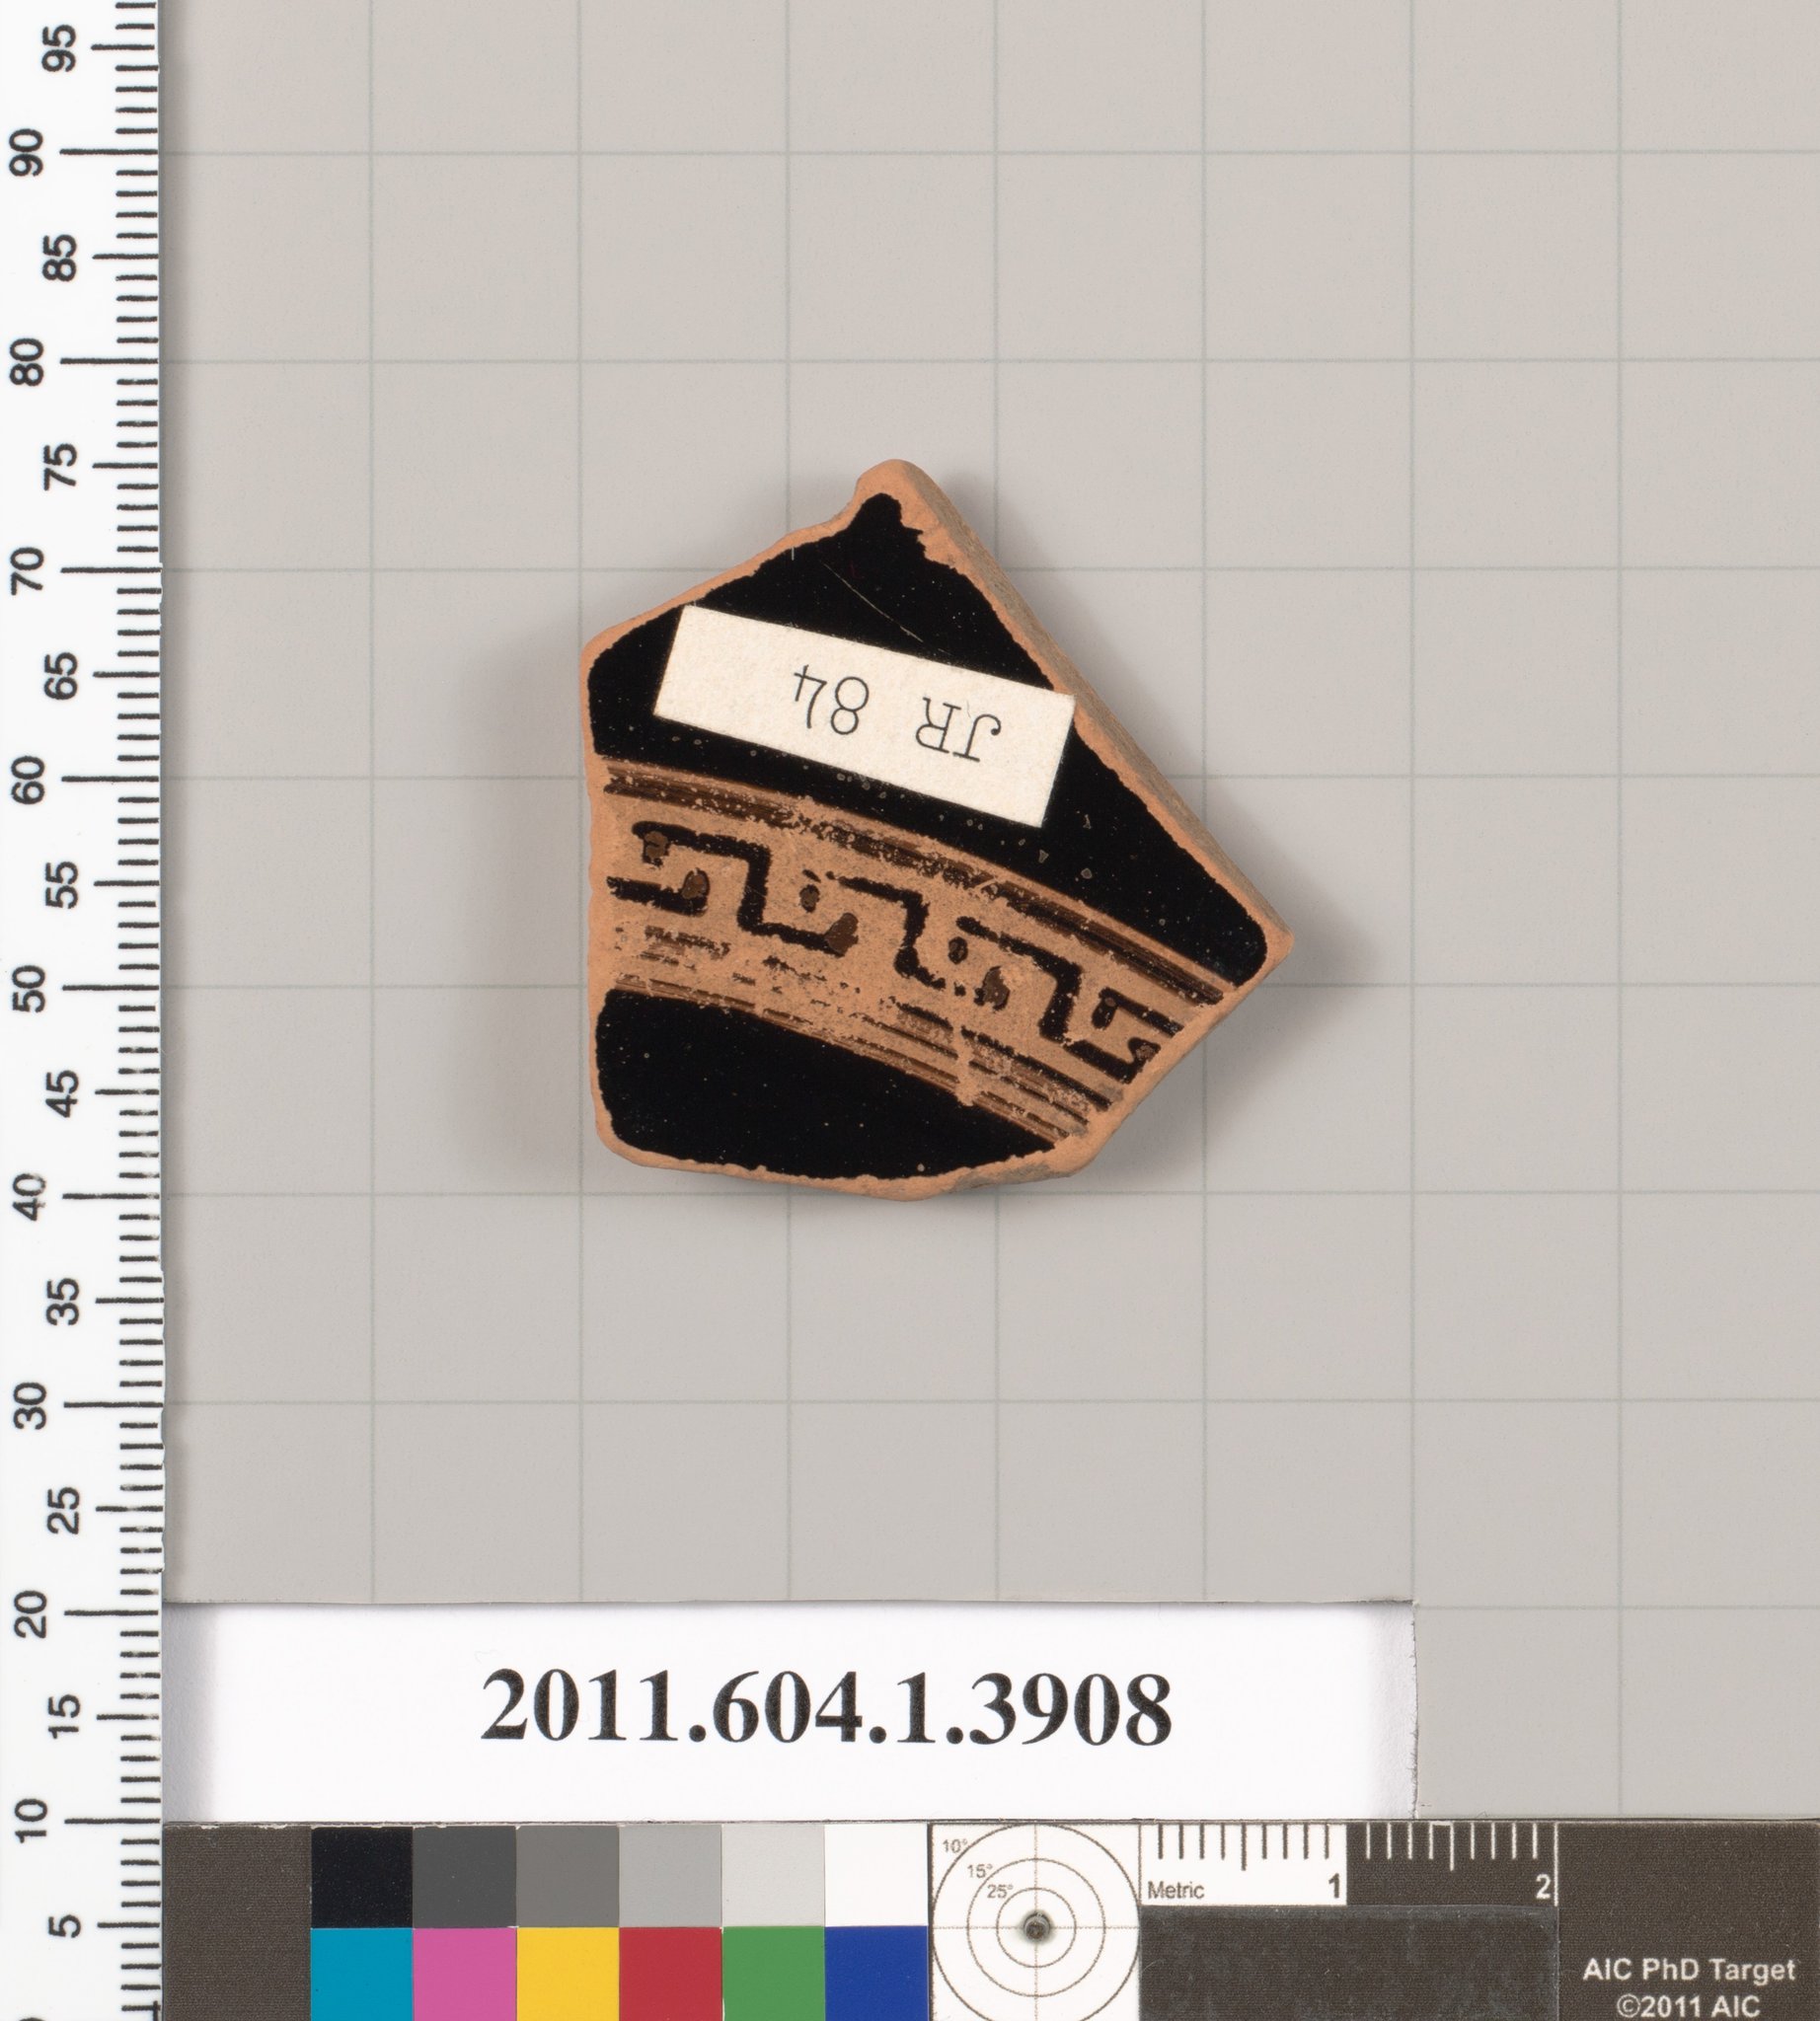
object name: kylix fragment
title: Terracotta fragment of a kylix (drinking cup)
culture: greek, attic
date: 500-476 BCE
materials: terracotta